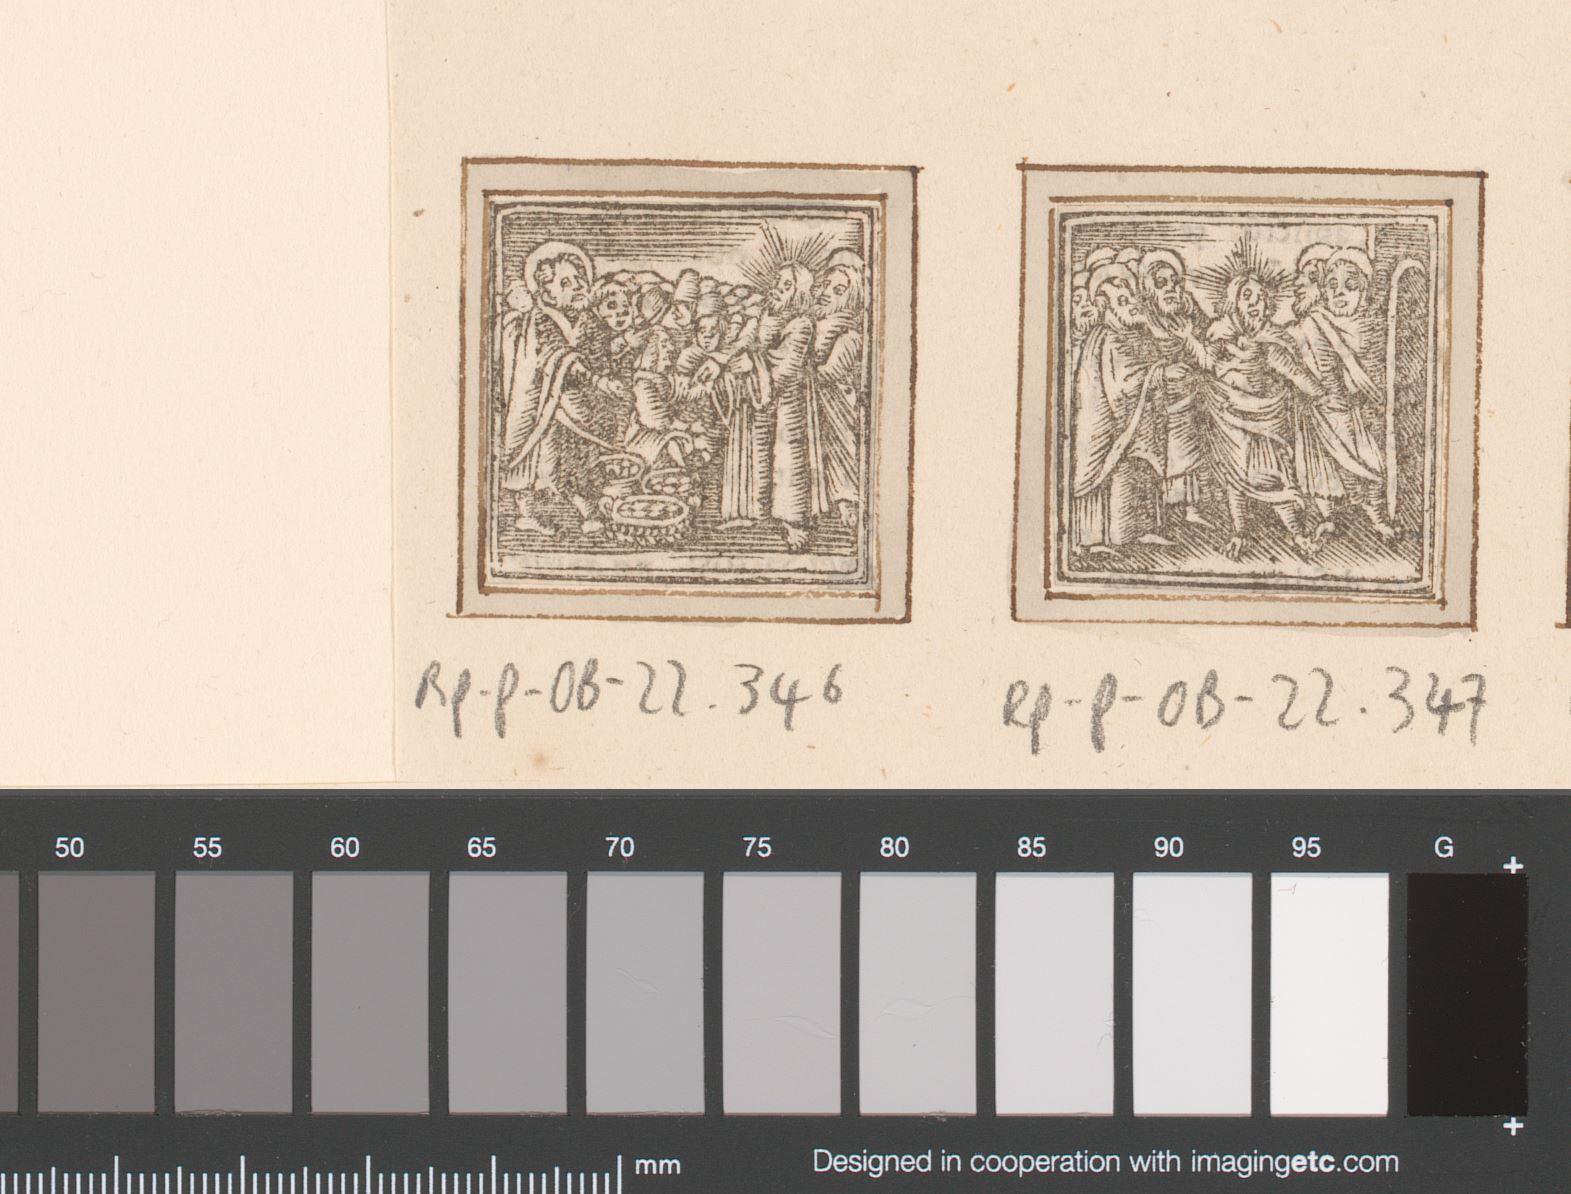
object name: book illustration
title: Wonderbare spijziging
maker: Anonymous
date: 1590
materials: paper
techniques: woodcut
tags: multiplication of loaves and fishes for a multitude of four or five thousand people (matthew 14:13-21, 15:32-39; mark 6:32-44, 8:1-10; luke 9:10-17; john 6:1-14)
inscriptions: collector's mark: Lugt 240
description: Prent afkomstig uit een onbekende Latijnse bijbel, mogelijk gedateerd 1590.